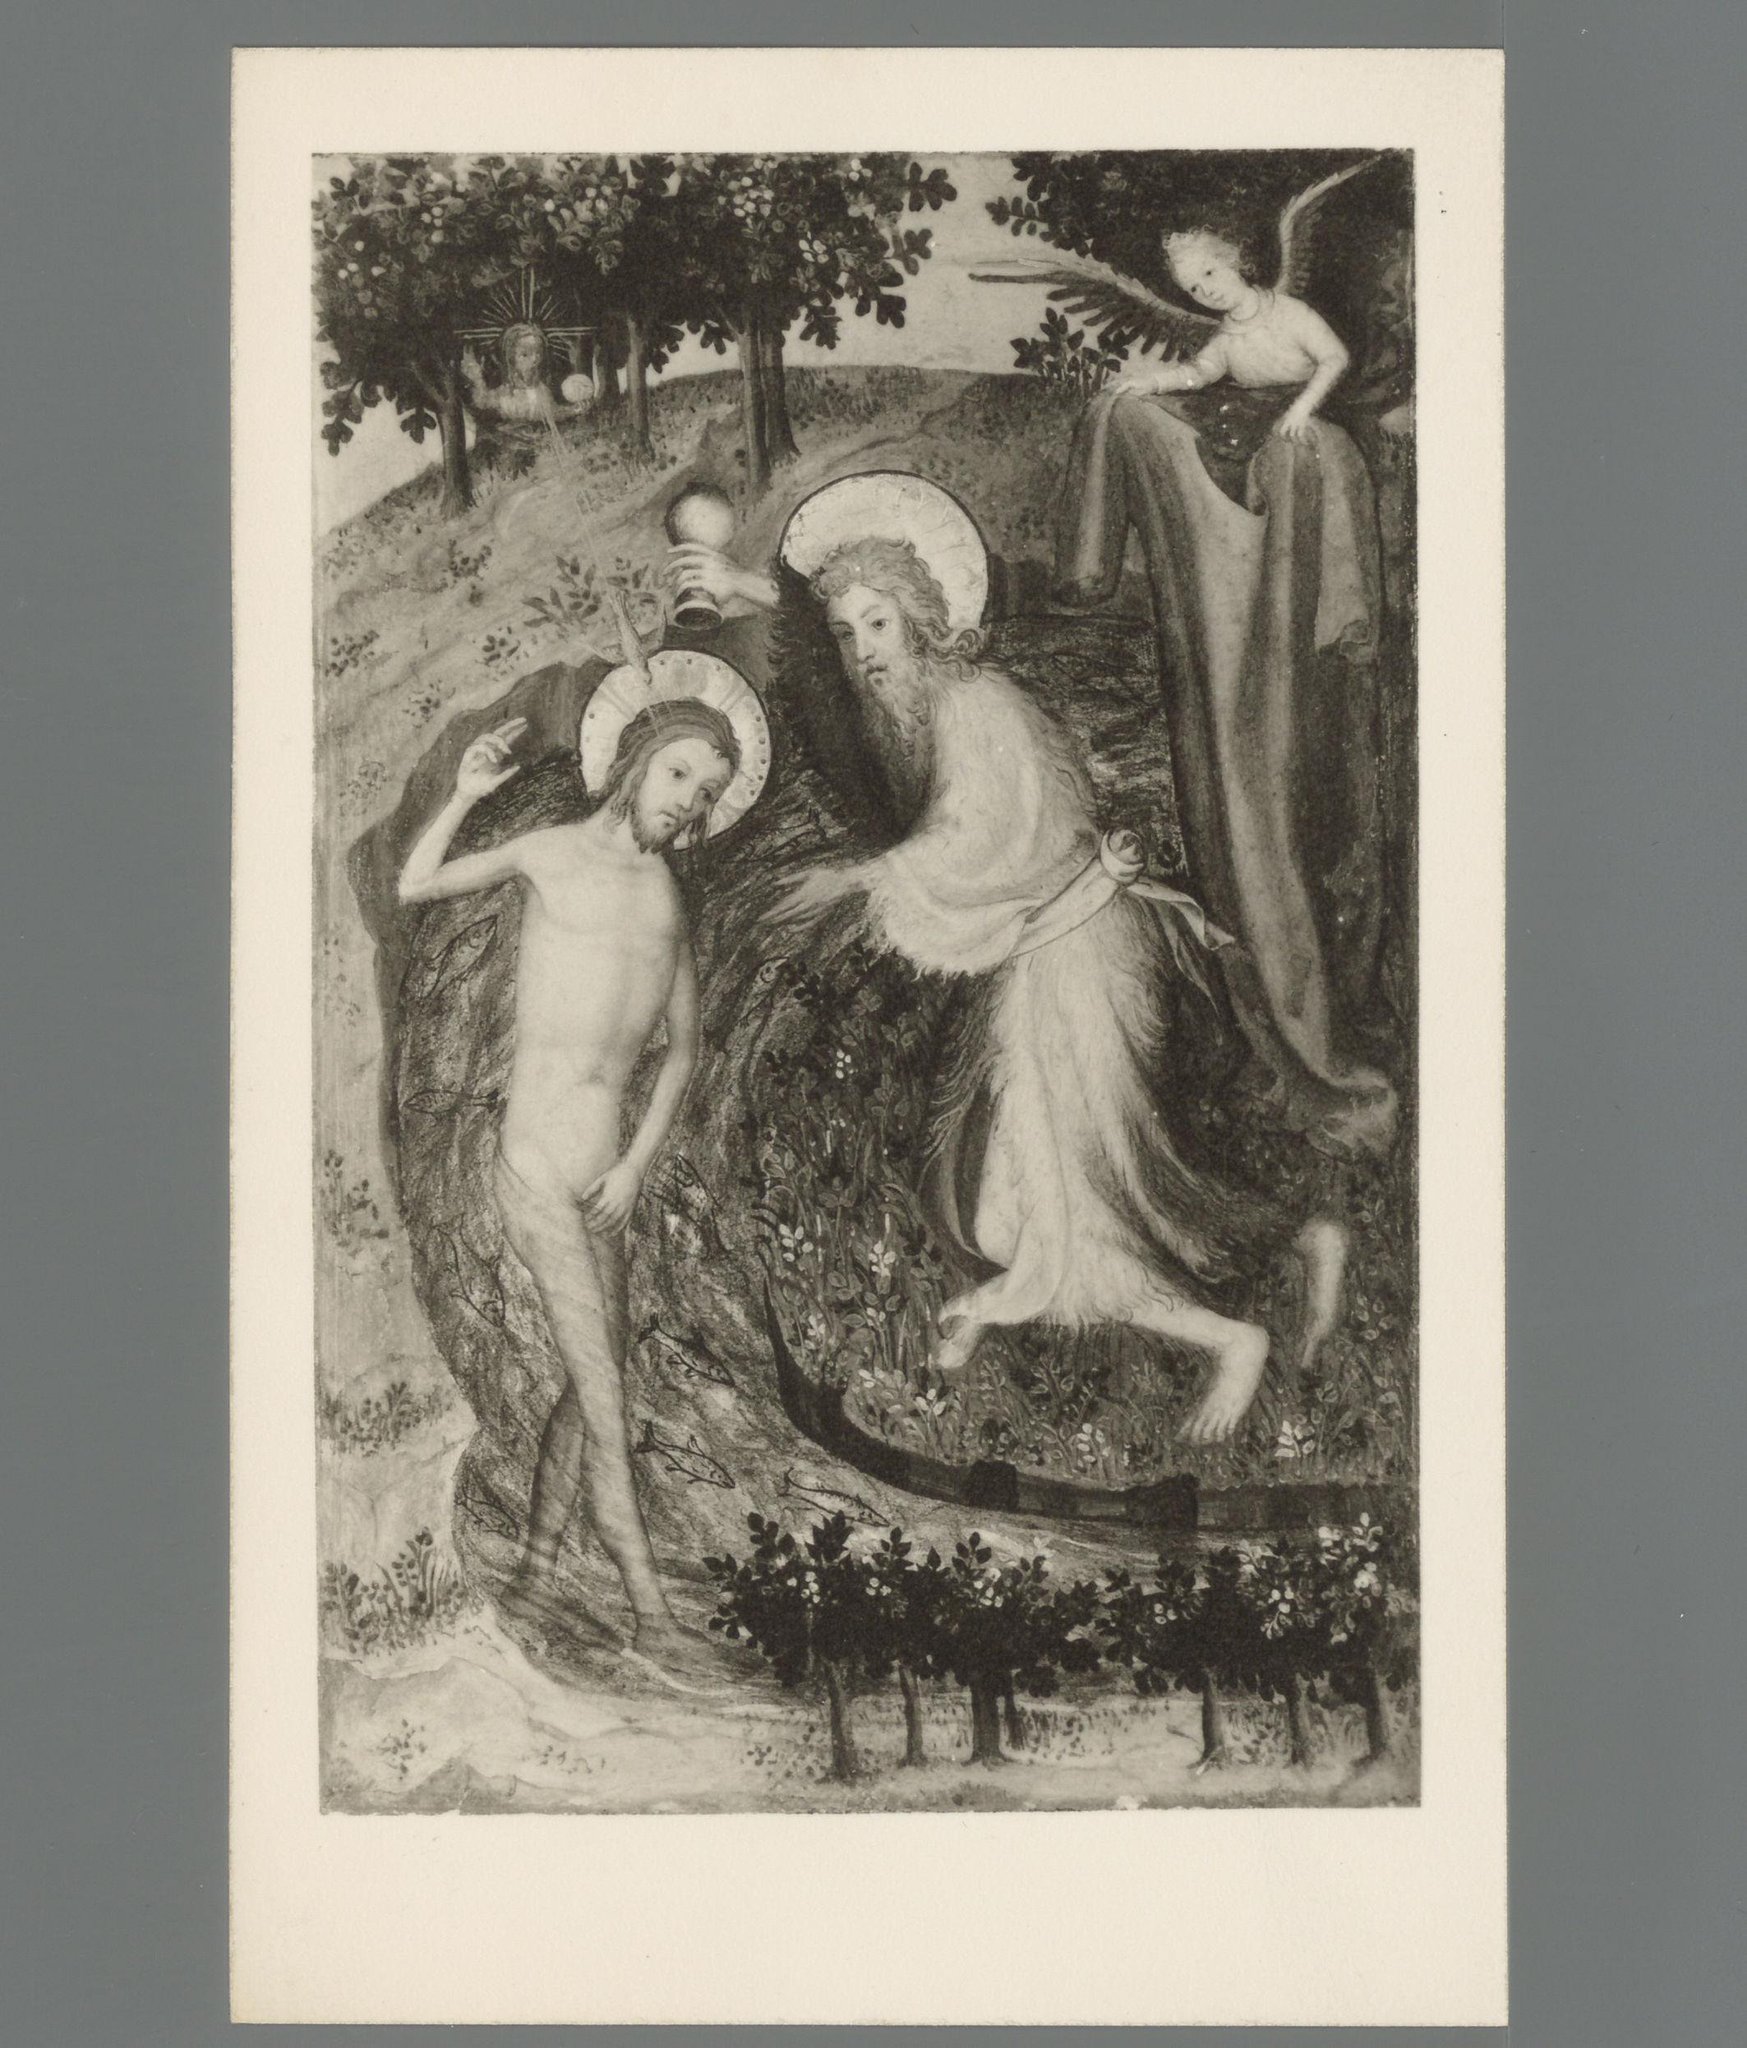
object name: photograph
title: The baptism of Christ. Section of an altarpiece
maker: Anonymous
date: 1939-1960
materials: photographic support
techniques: photography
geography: baltimore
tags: story of john the baptist (matthew 3; mark 1:4-11; luke 3:1-22; john 1:19-34), angels